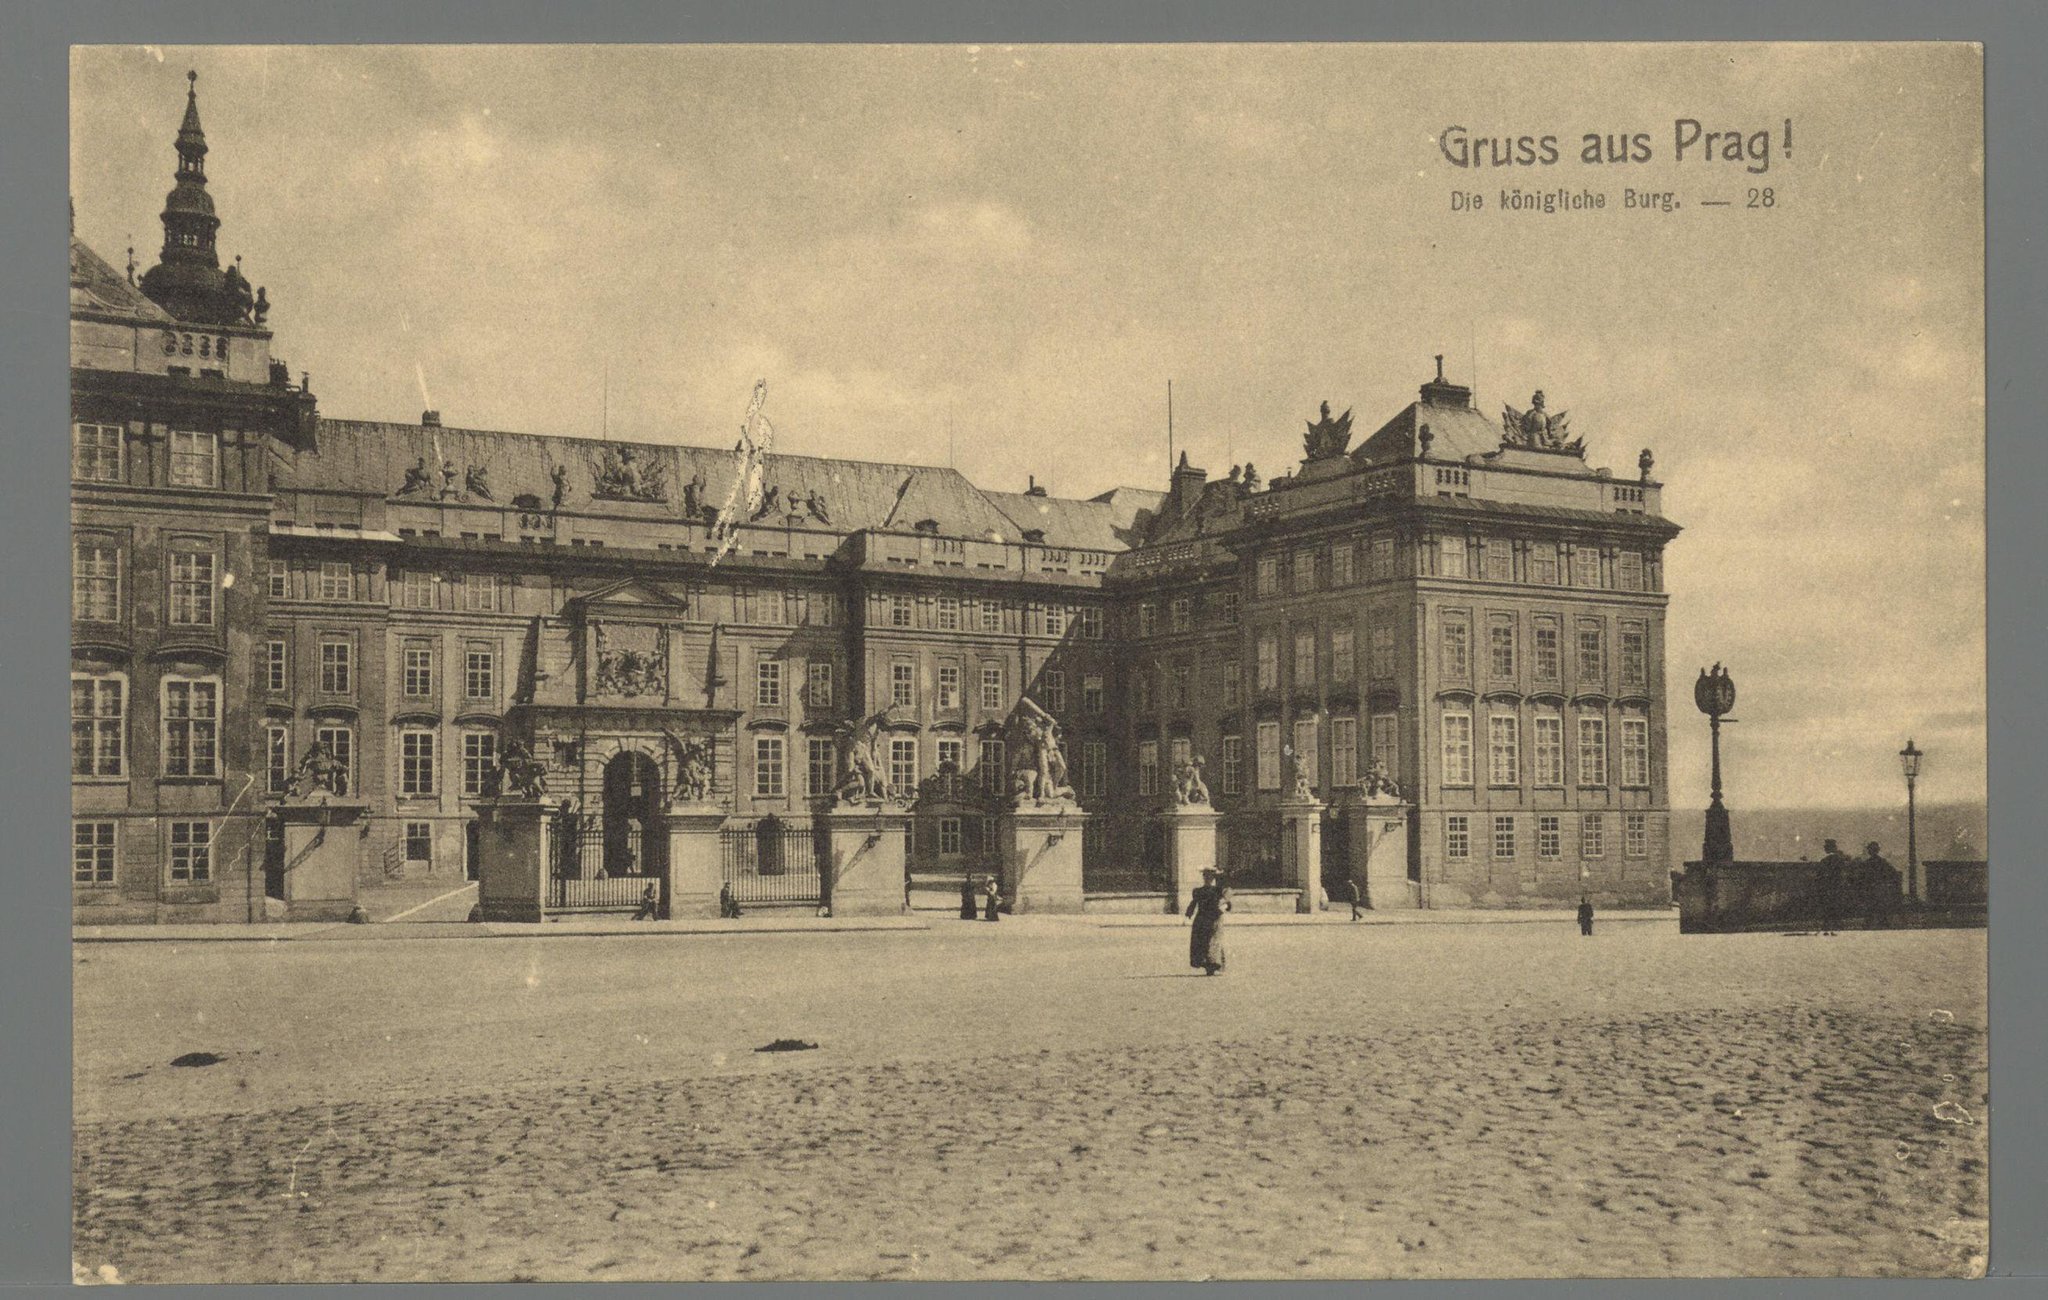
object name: photomechanical print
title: Gruss aus Prag! Die königliche Burg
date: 1908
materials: cardboard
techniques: photograph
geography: prague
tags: castle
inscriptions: date